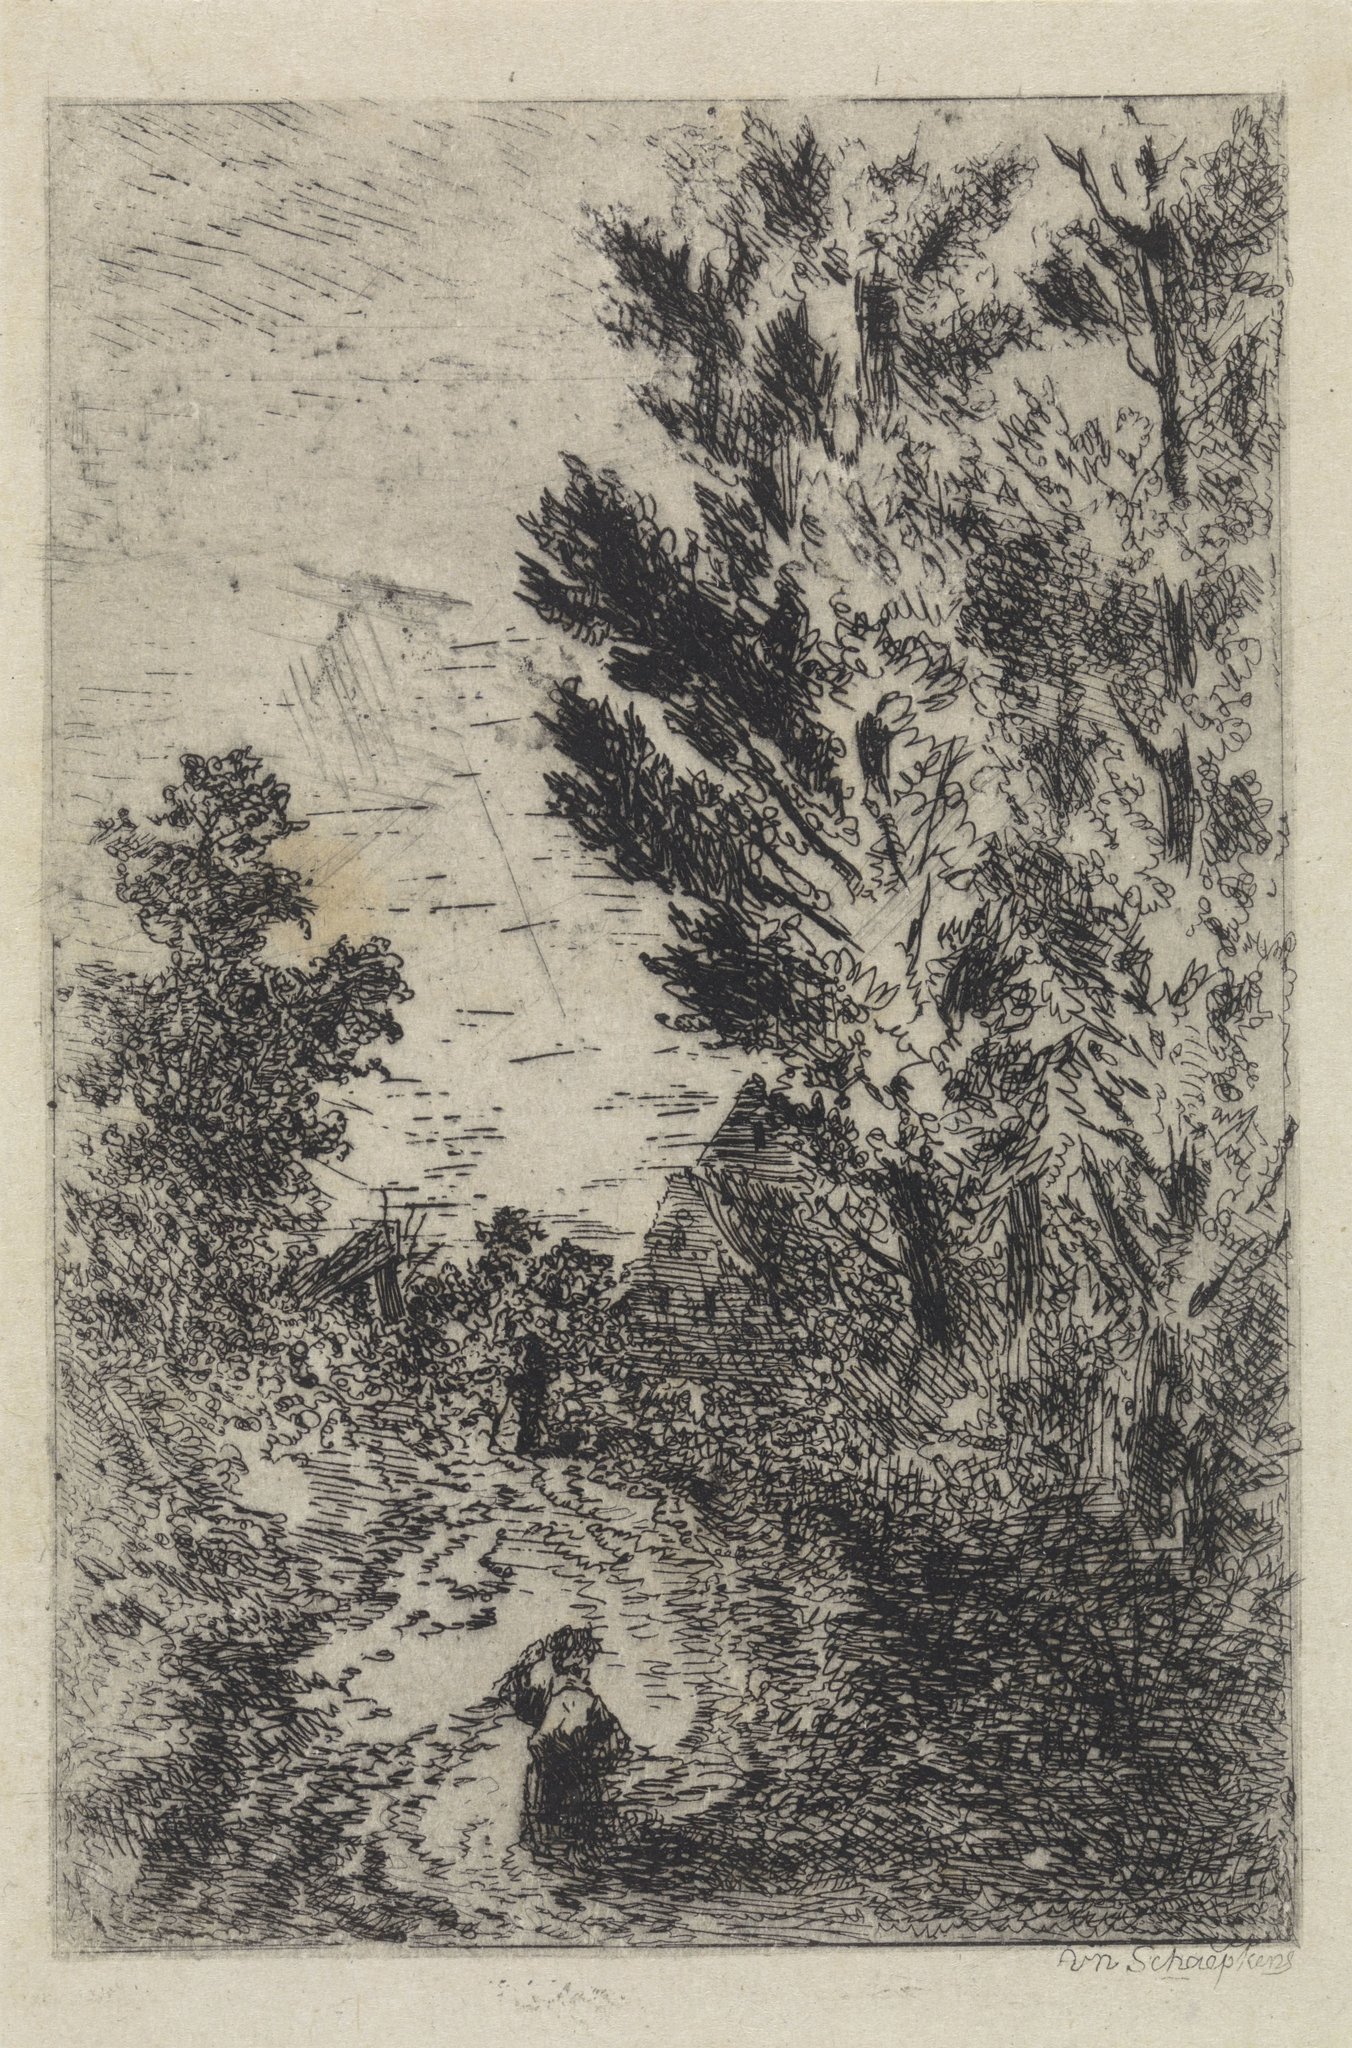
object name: print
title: Landweg met wandelaars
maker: arnoud schaepkens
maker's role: print maker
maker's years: 1816-1904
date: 1831-1904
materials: paper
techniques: drypoint, etching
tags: landscapes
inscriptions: collector's mark: Lugt 2228